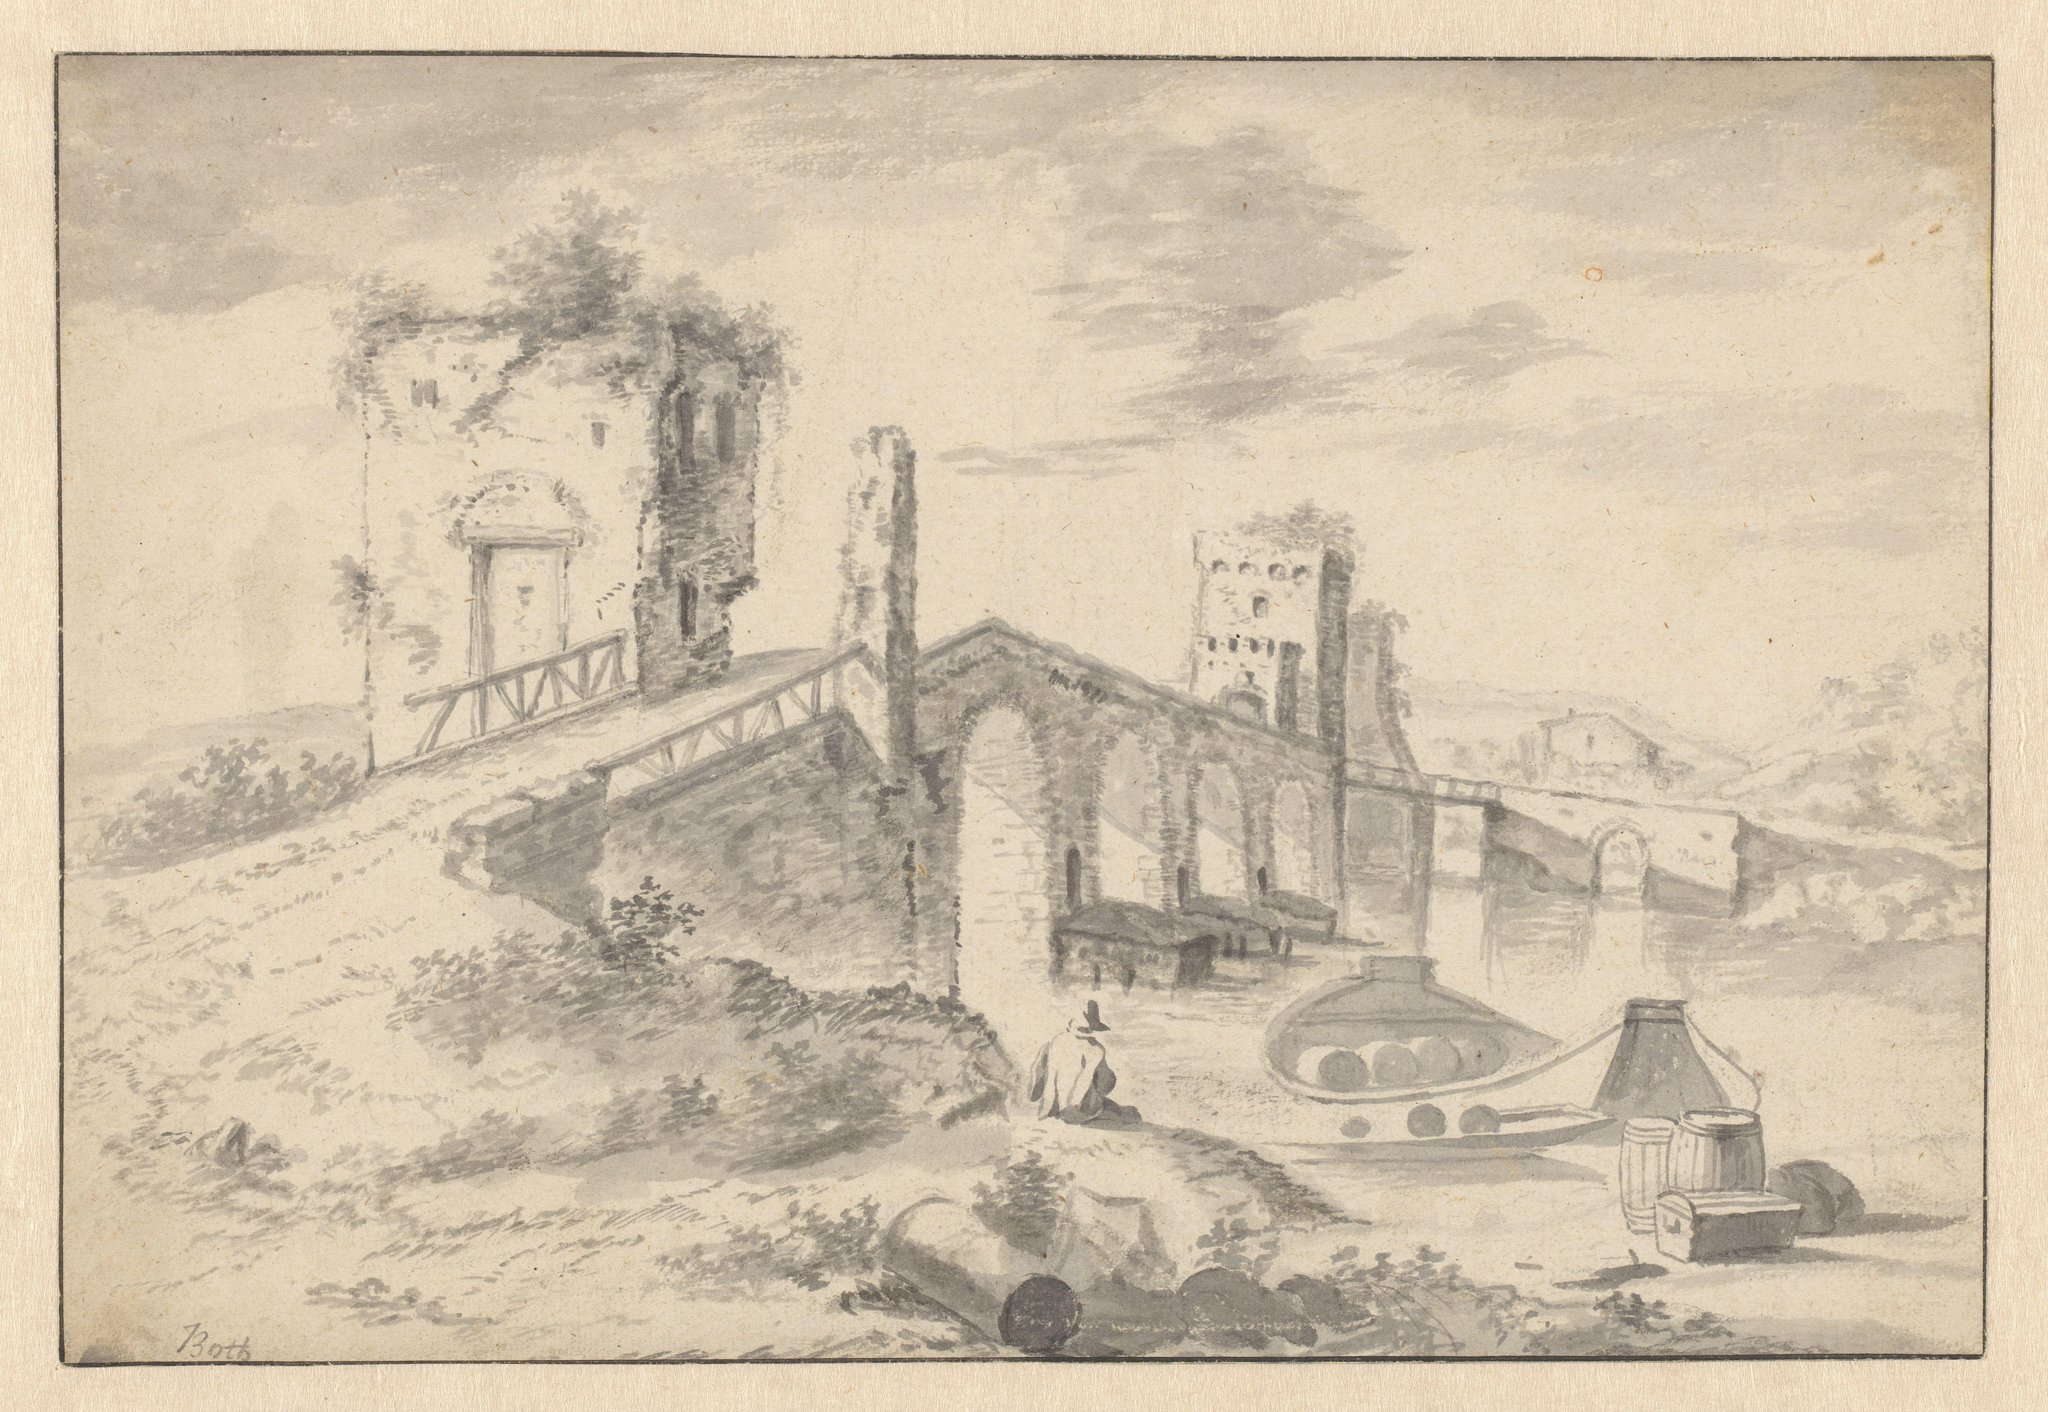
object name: drawing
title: Ponte Molle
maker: Anonymous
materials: graphite, ink, paper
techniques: brush, pen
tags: landscape with bridge, viaduct or aqueduct